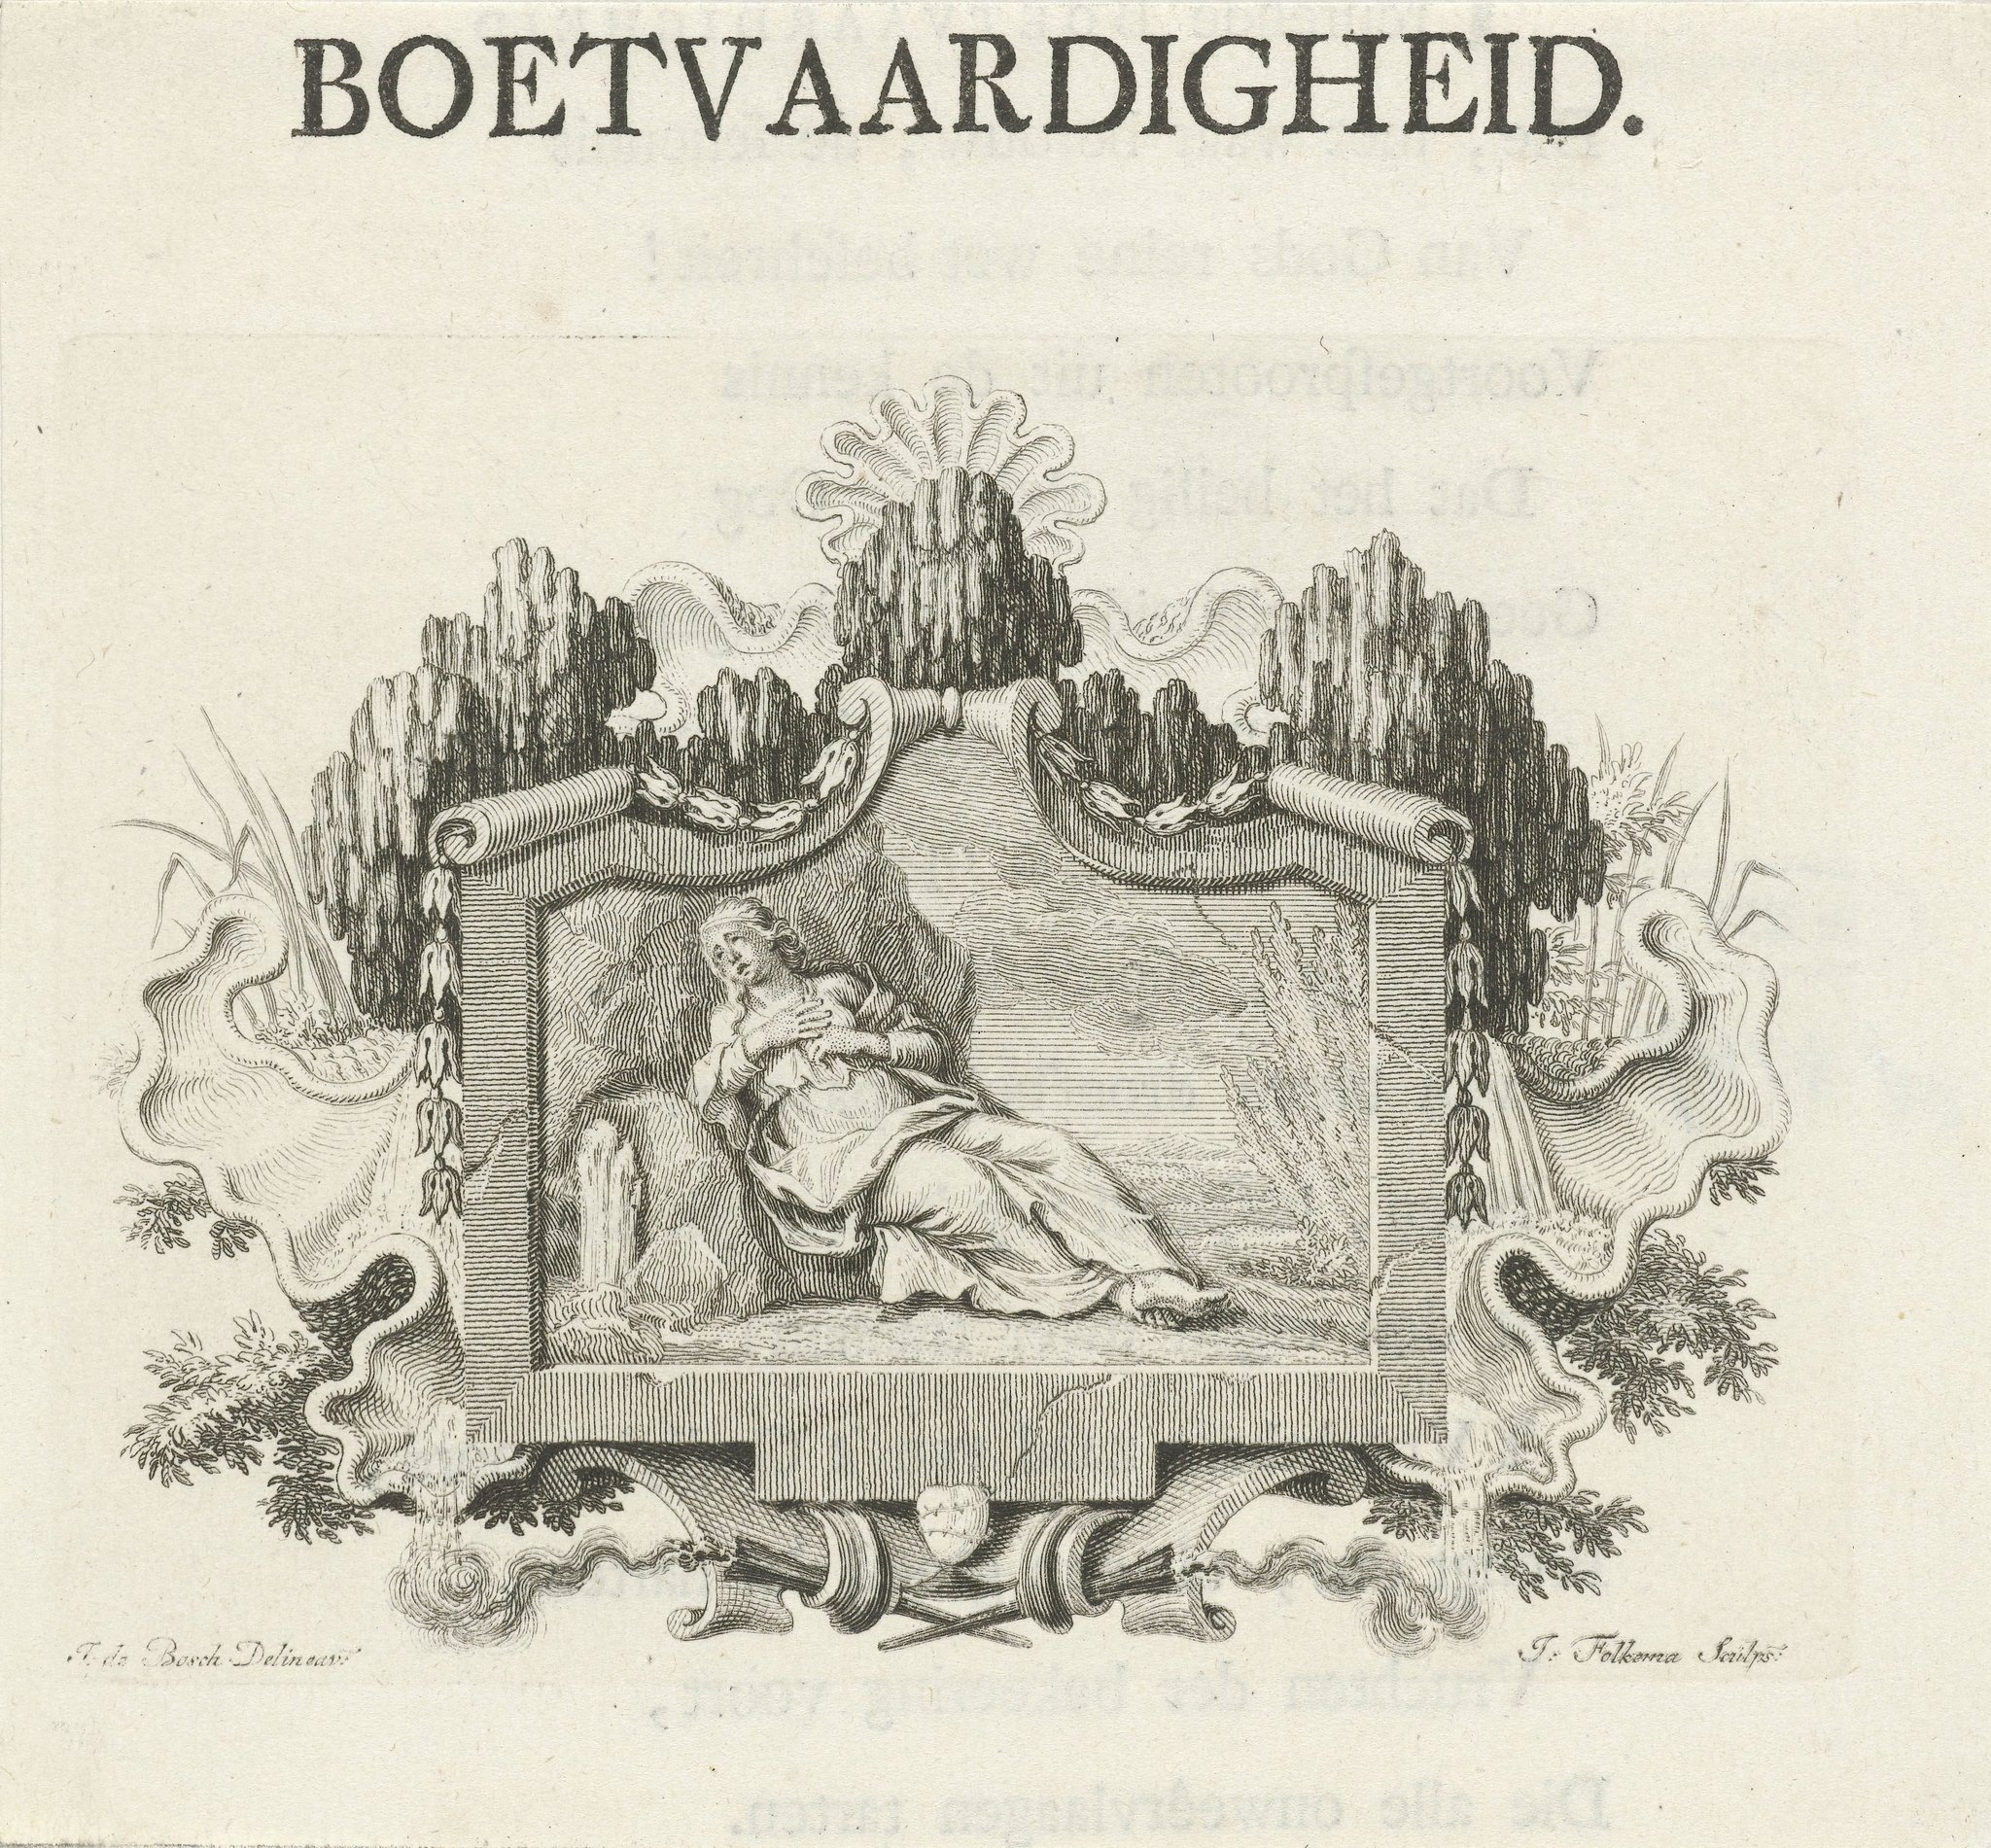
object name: print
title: Vignet met de personificatie van Boetvaardigheid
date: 1723-1767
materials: paper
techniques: etching, letterpress printing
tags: penance, 'poenitentia'; 'contritione' (ripa) ~ part of the confession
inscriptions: collector's mark: Lugt 2228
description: Vignet met de beeltenis van de gepersonifieerde Boetvaardigheid in een ornamentele omlijsting. De lijst is opgebouwd uit een cartouche en schelppatronen, geheel onderaan is een met prikkeldraad omwonden hart weergegeven. De Boetvaardigheid leunt tegen een steen en houdt haar handen op haar borst terwijl ze berouwvol omhoog kijkt. De prent maakt deel uit van een reeks boekillustraties over deugden en ondeugden.